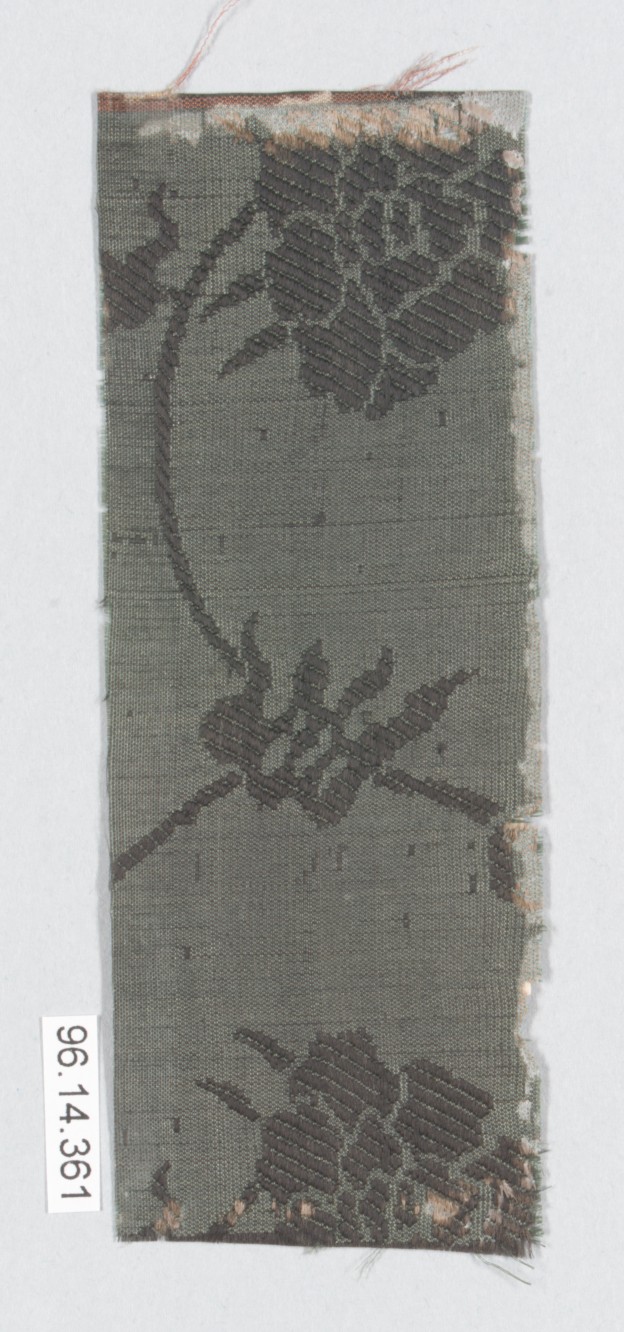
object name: piece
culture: japanese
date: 1701-1900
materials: silk